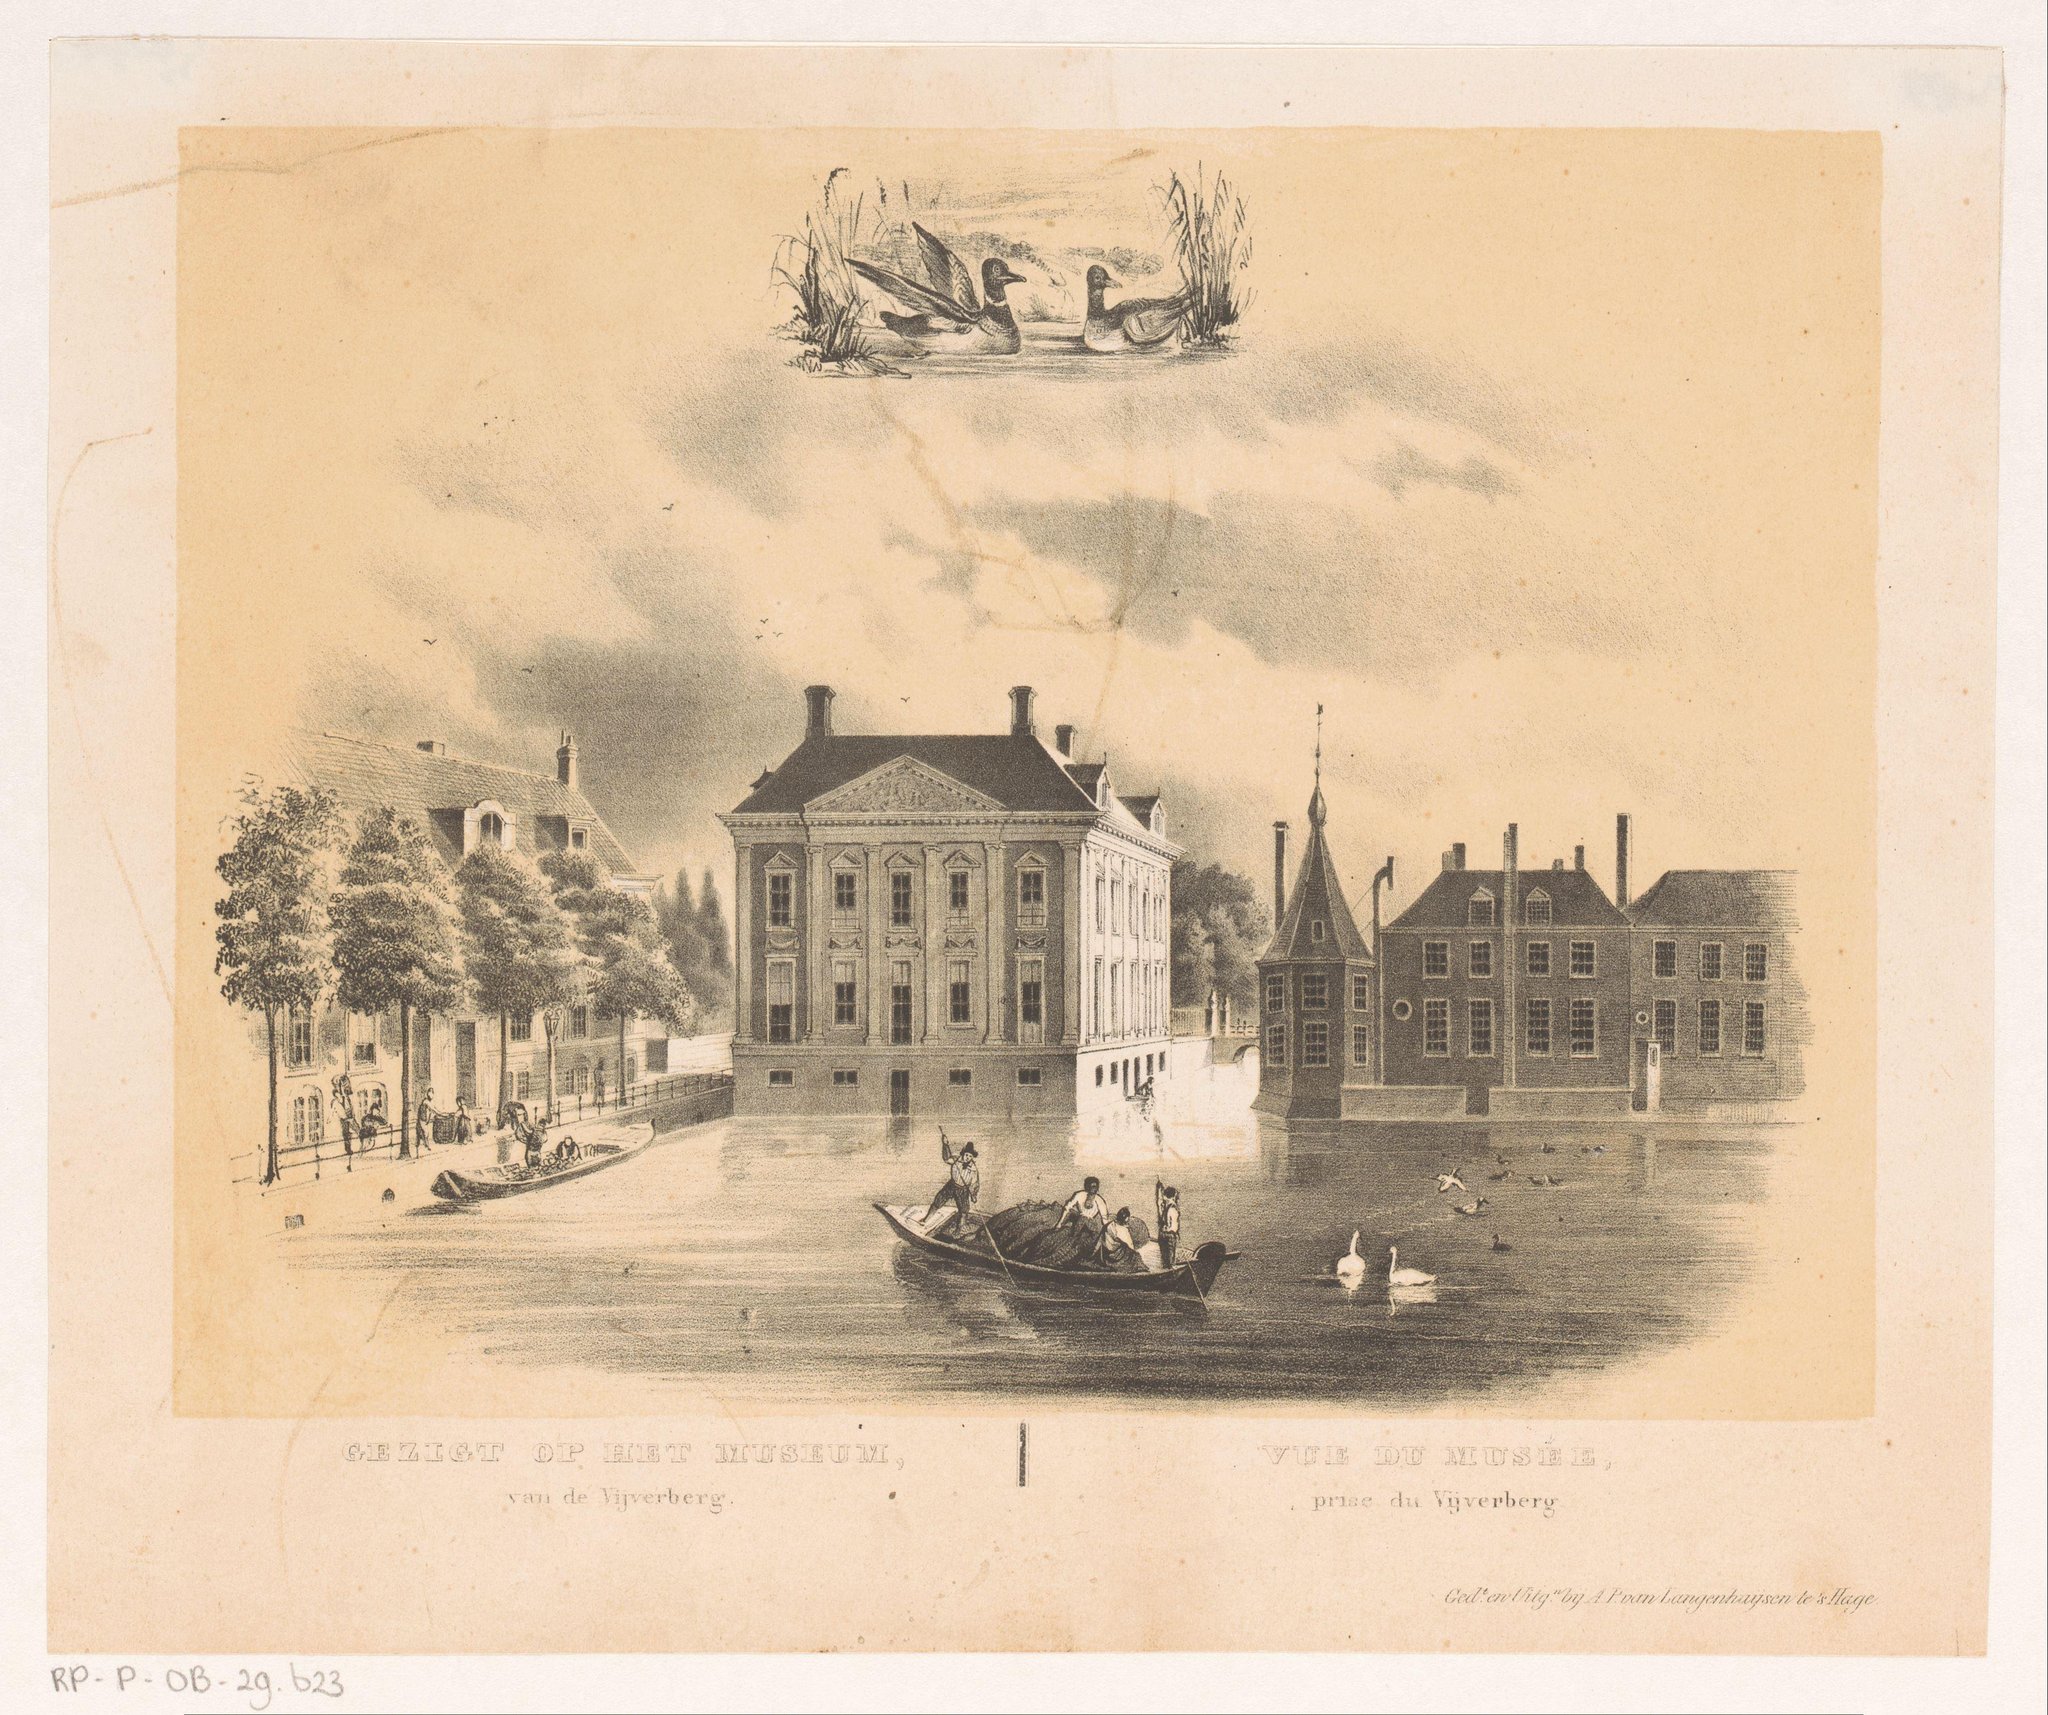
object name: print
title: Mauritshuis en hofvijver te Den Haag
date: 1830-1846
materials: paper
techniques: tone lithography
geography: the hague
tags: permanent exhibition, museum, pond, pool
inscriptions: collector's mark: Lugt 2228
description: Gezicht op de achterzijde van het Mauritshuis met daarvoor een boot varend op de Hofvijver. Rechts een deel van het Binnenhof met rechts het torentje.